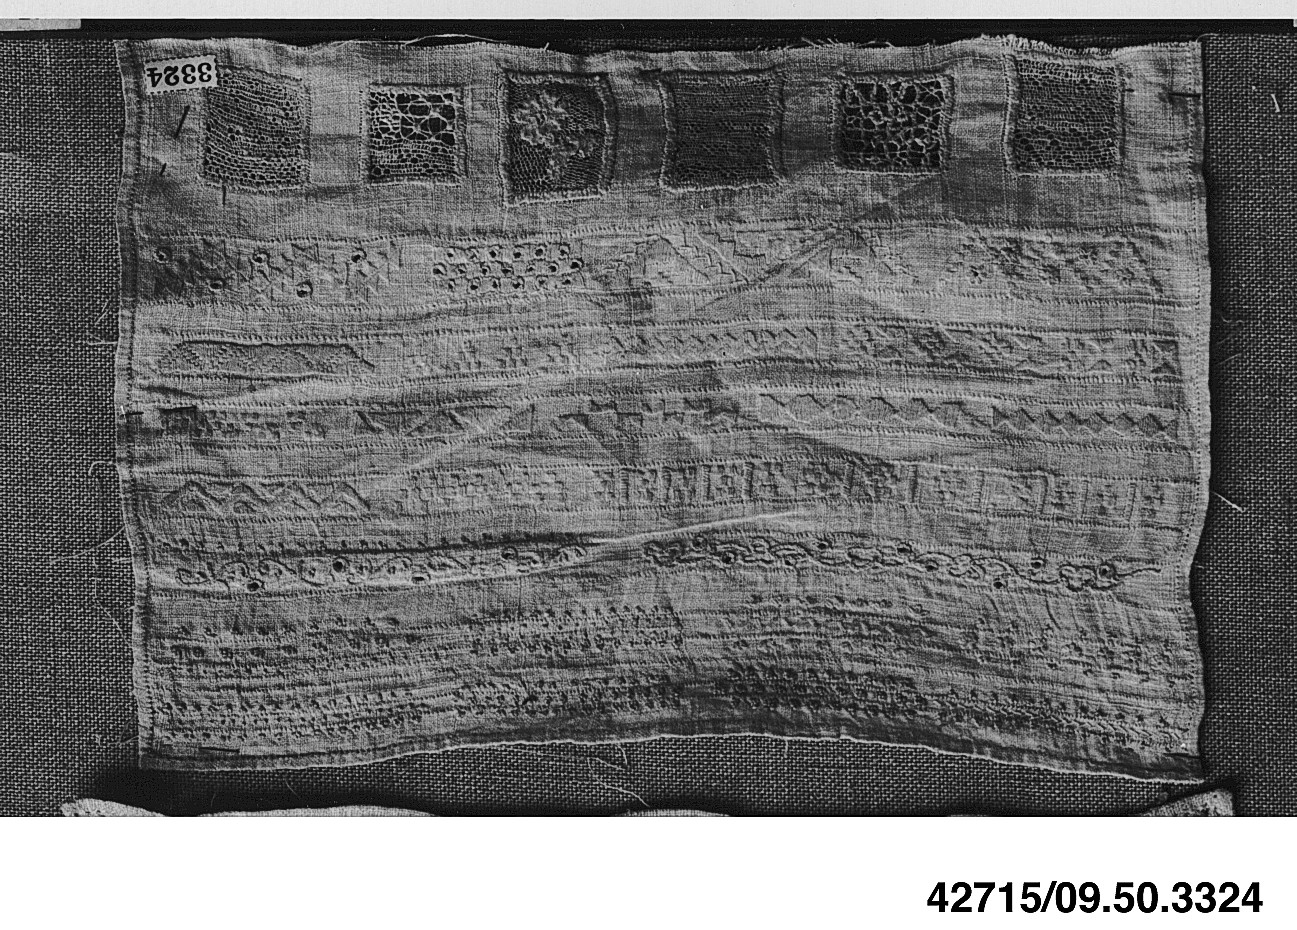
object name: sampler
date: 1701-1800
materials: linen